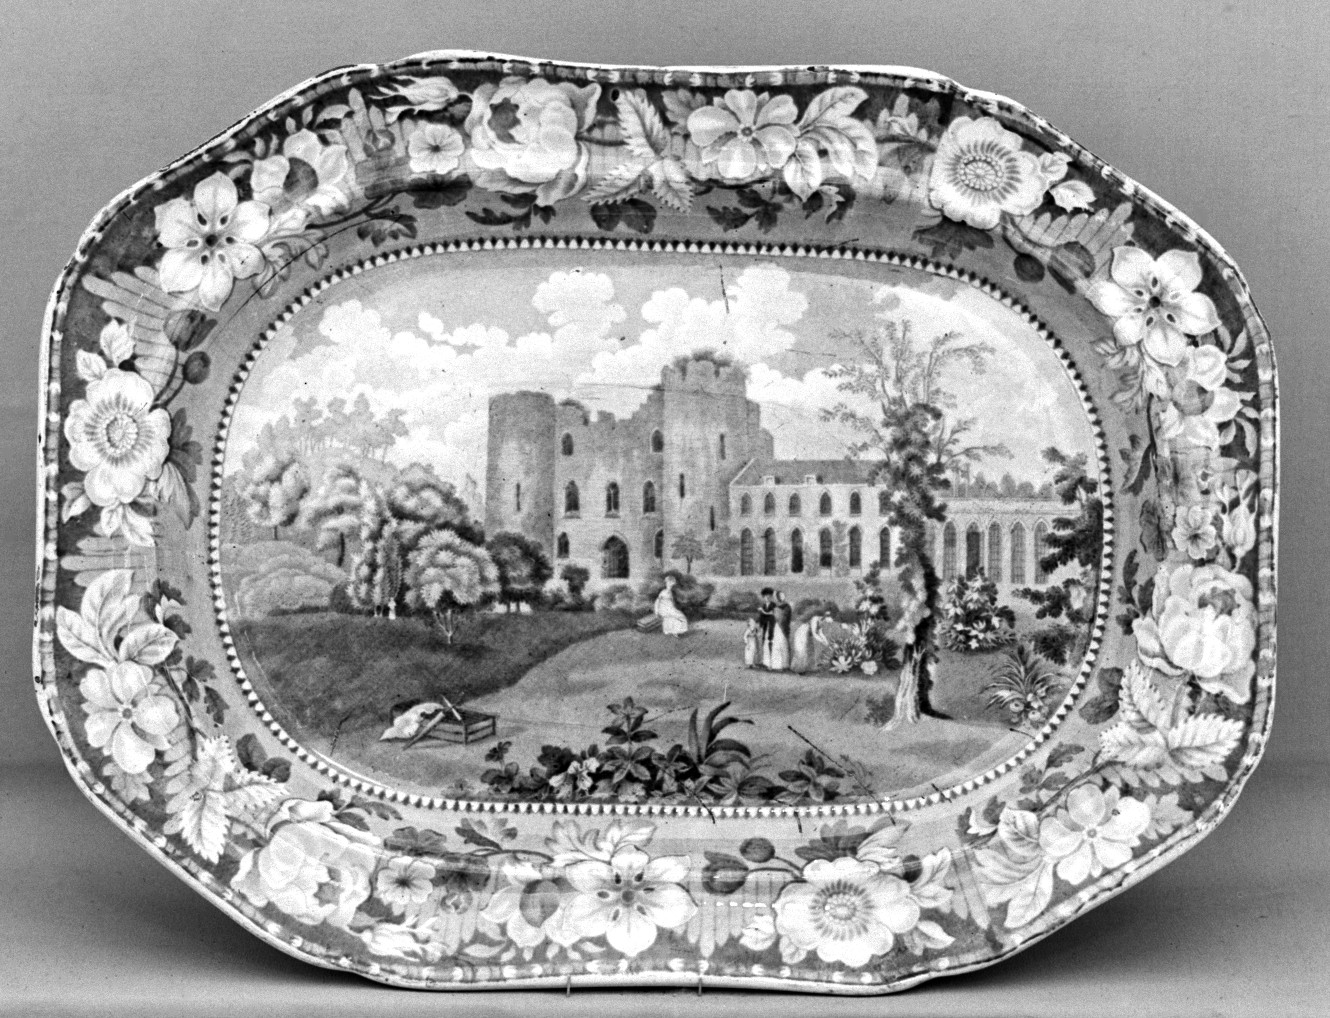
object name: platter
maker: a. stevenson, cobridge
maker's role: factory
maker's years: 1820-1840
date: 1801-1900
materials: pottery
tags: buildings,flowers,trees